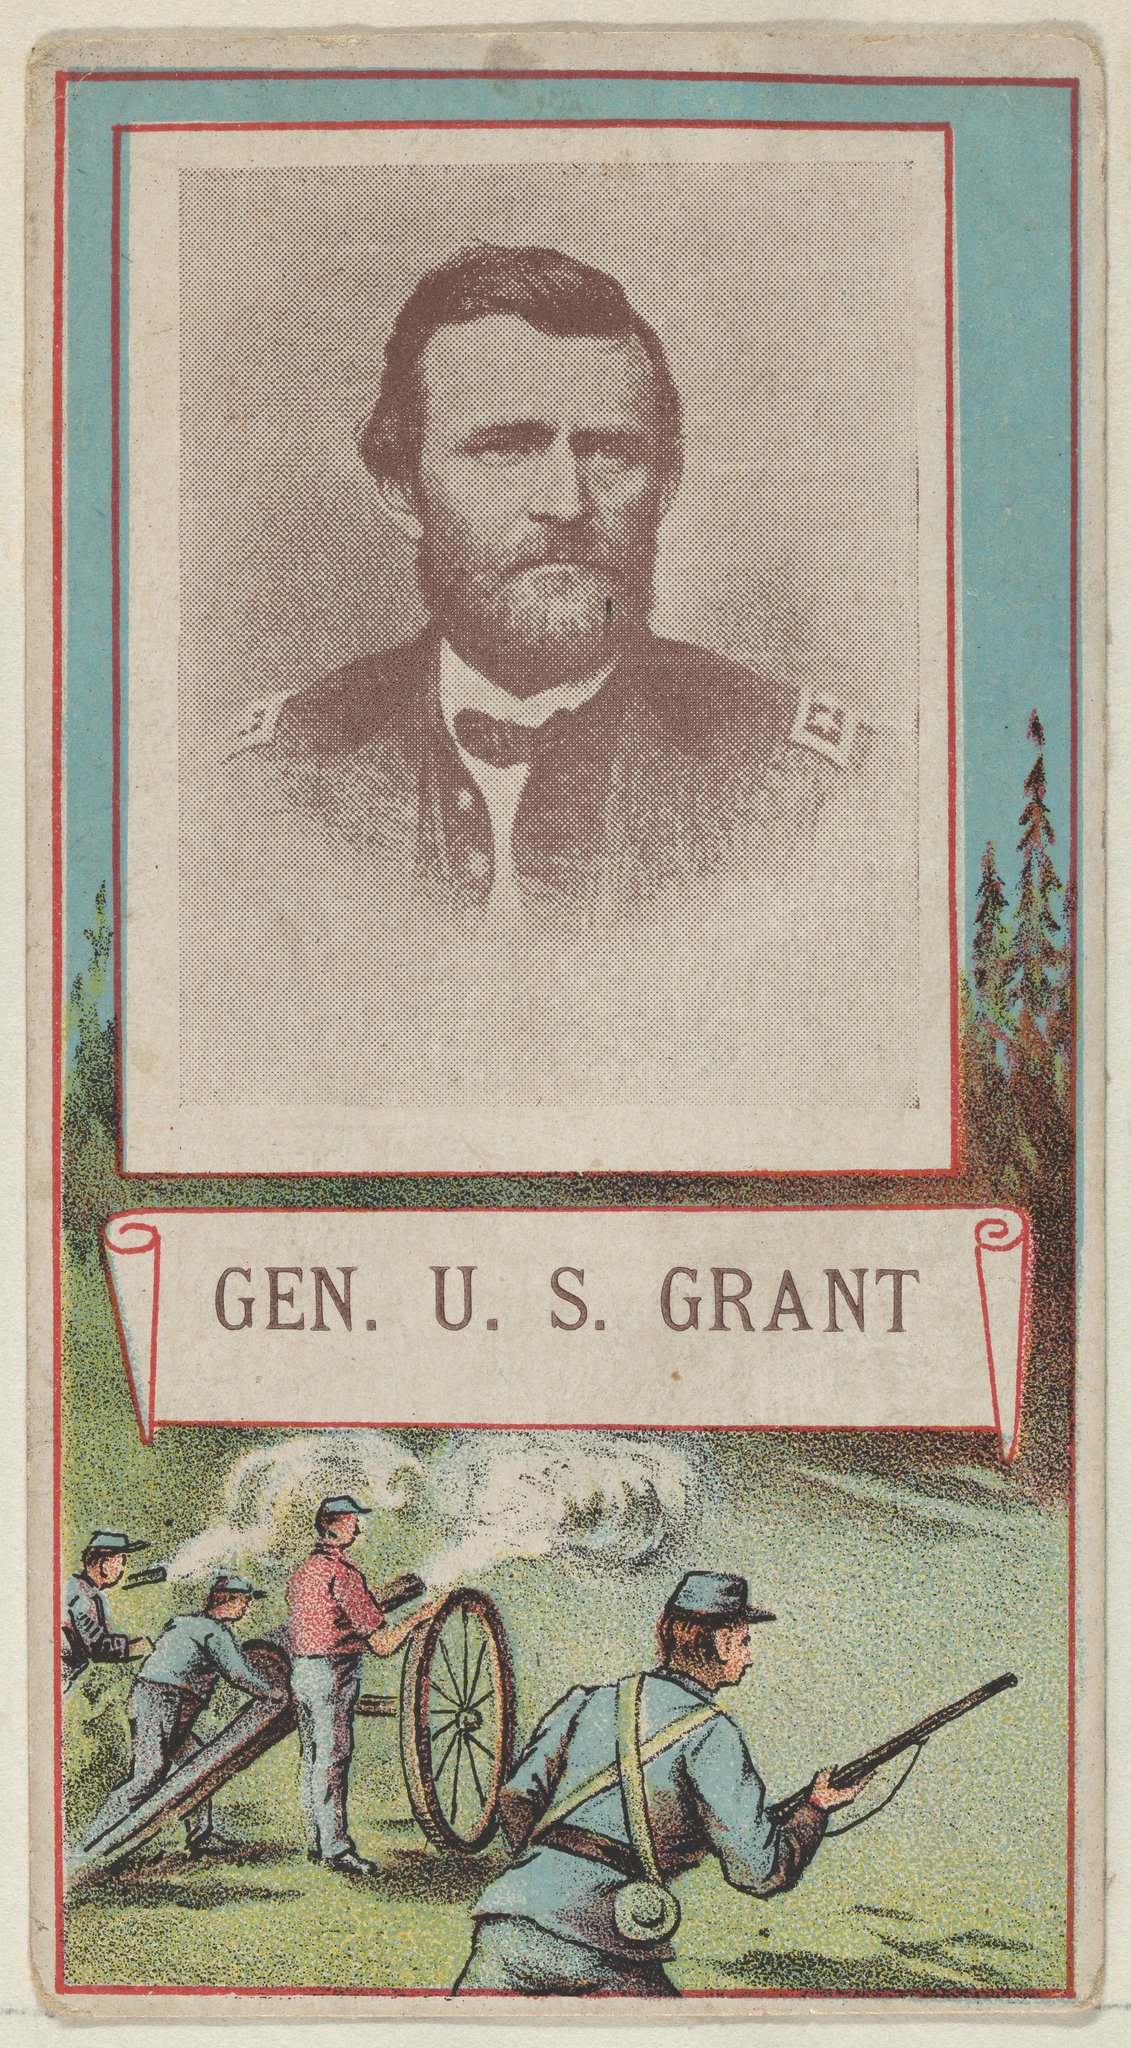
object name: print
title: General Ulysses S. Grant, from the "Generals" series (T64), issued by D.H. McAlpin & Co. Tobacco Company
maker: d.h. mcalpin & co. tobacco company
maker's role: publisher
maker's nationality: american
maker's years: 1857-1901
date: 1901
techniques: color lithograph